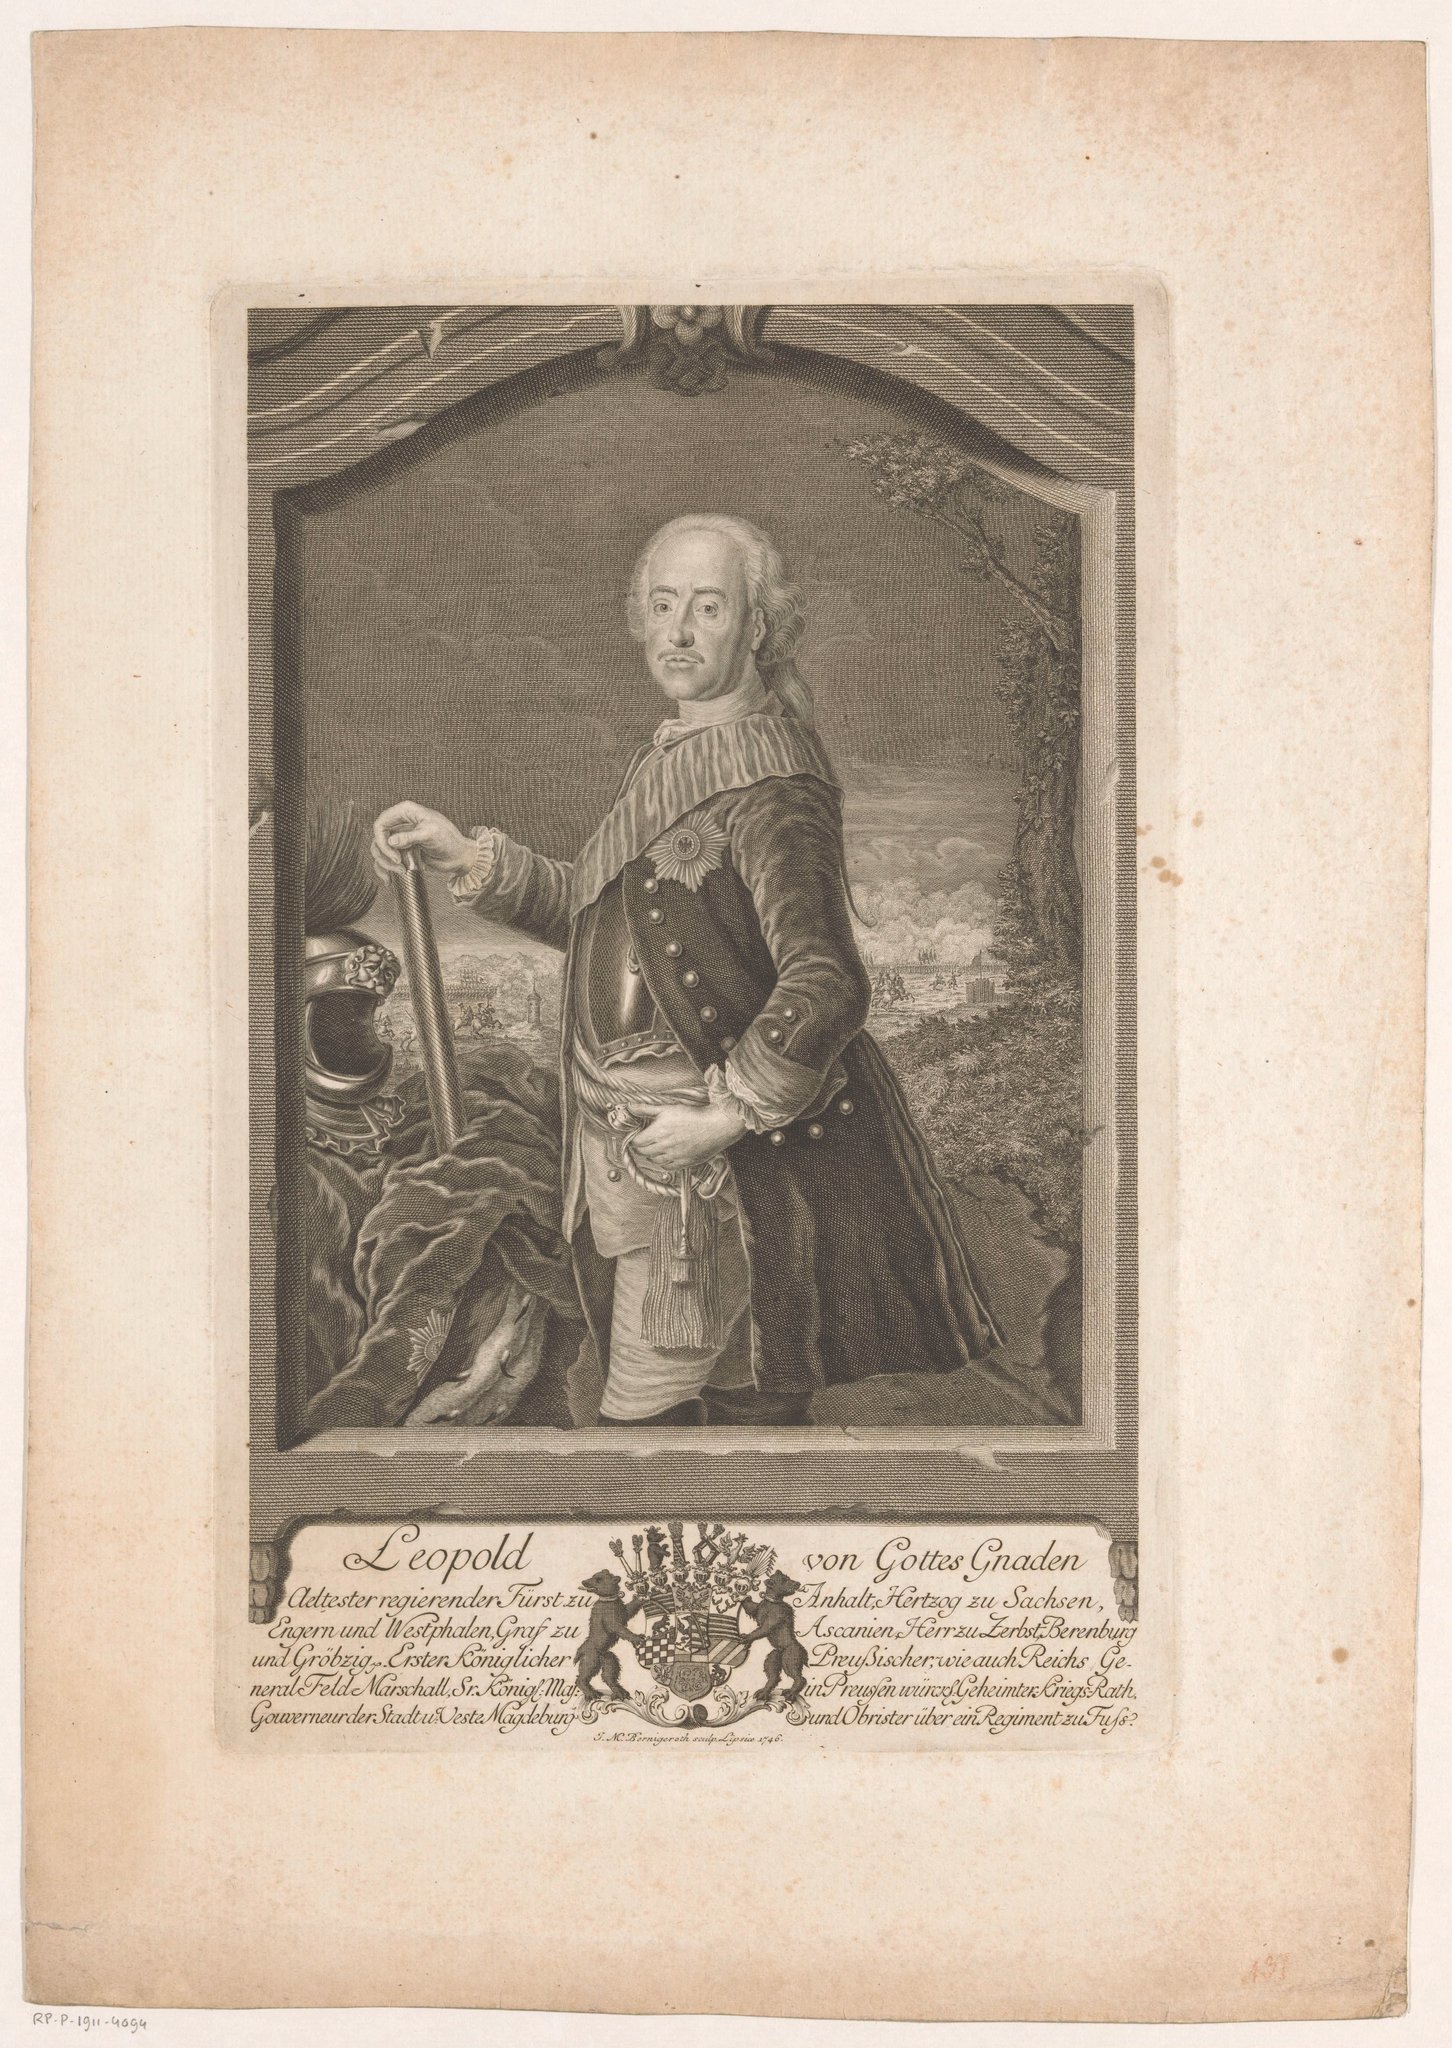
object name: print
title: Portret van Leopold I von Anhalt-Dessau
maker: johann martin bernigeroth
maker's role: print maker, publisher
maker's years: 1713-1767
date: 1723-1767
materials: paper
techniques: engraving, etching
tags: helmet, knighthood order (with name) - insignia of a knighthood order, e.g.: badge, chain (with name of order), armour, historical persons, baton of general, charge ~ battle, armorial bearing, heraldry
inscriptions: collector's mark: Lugt 2228